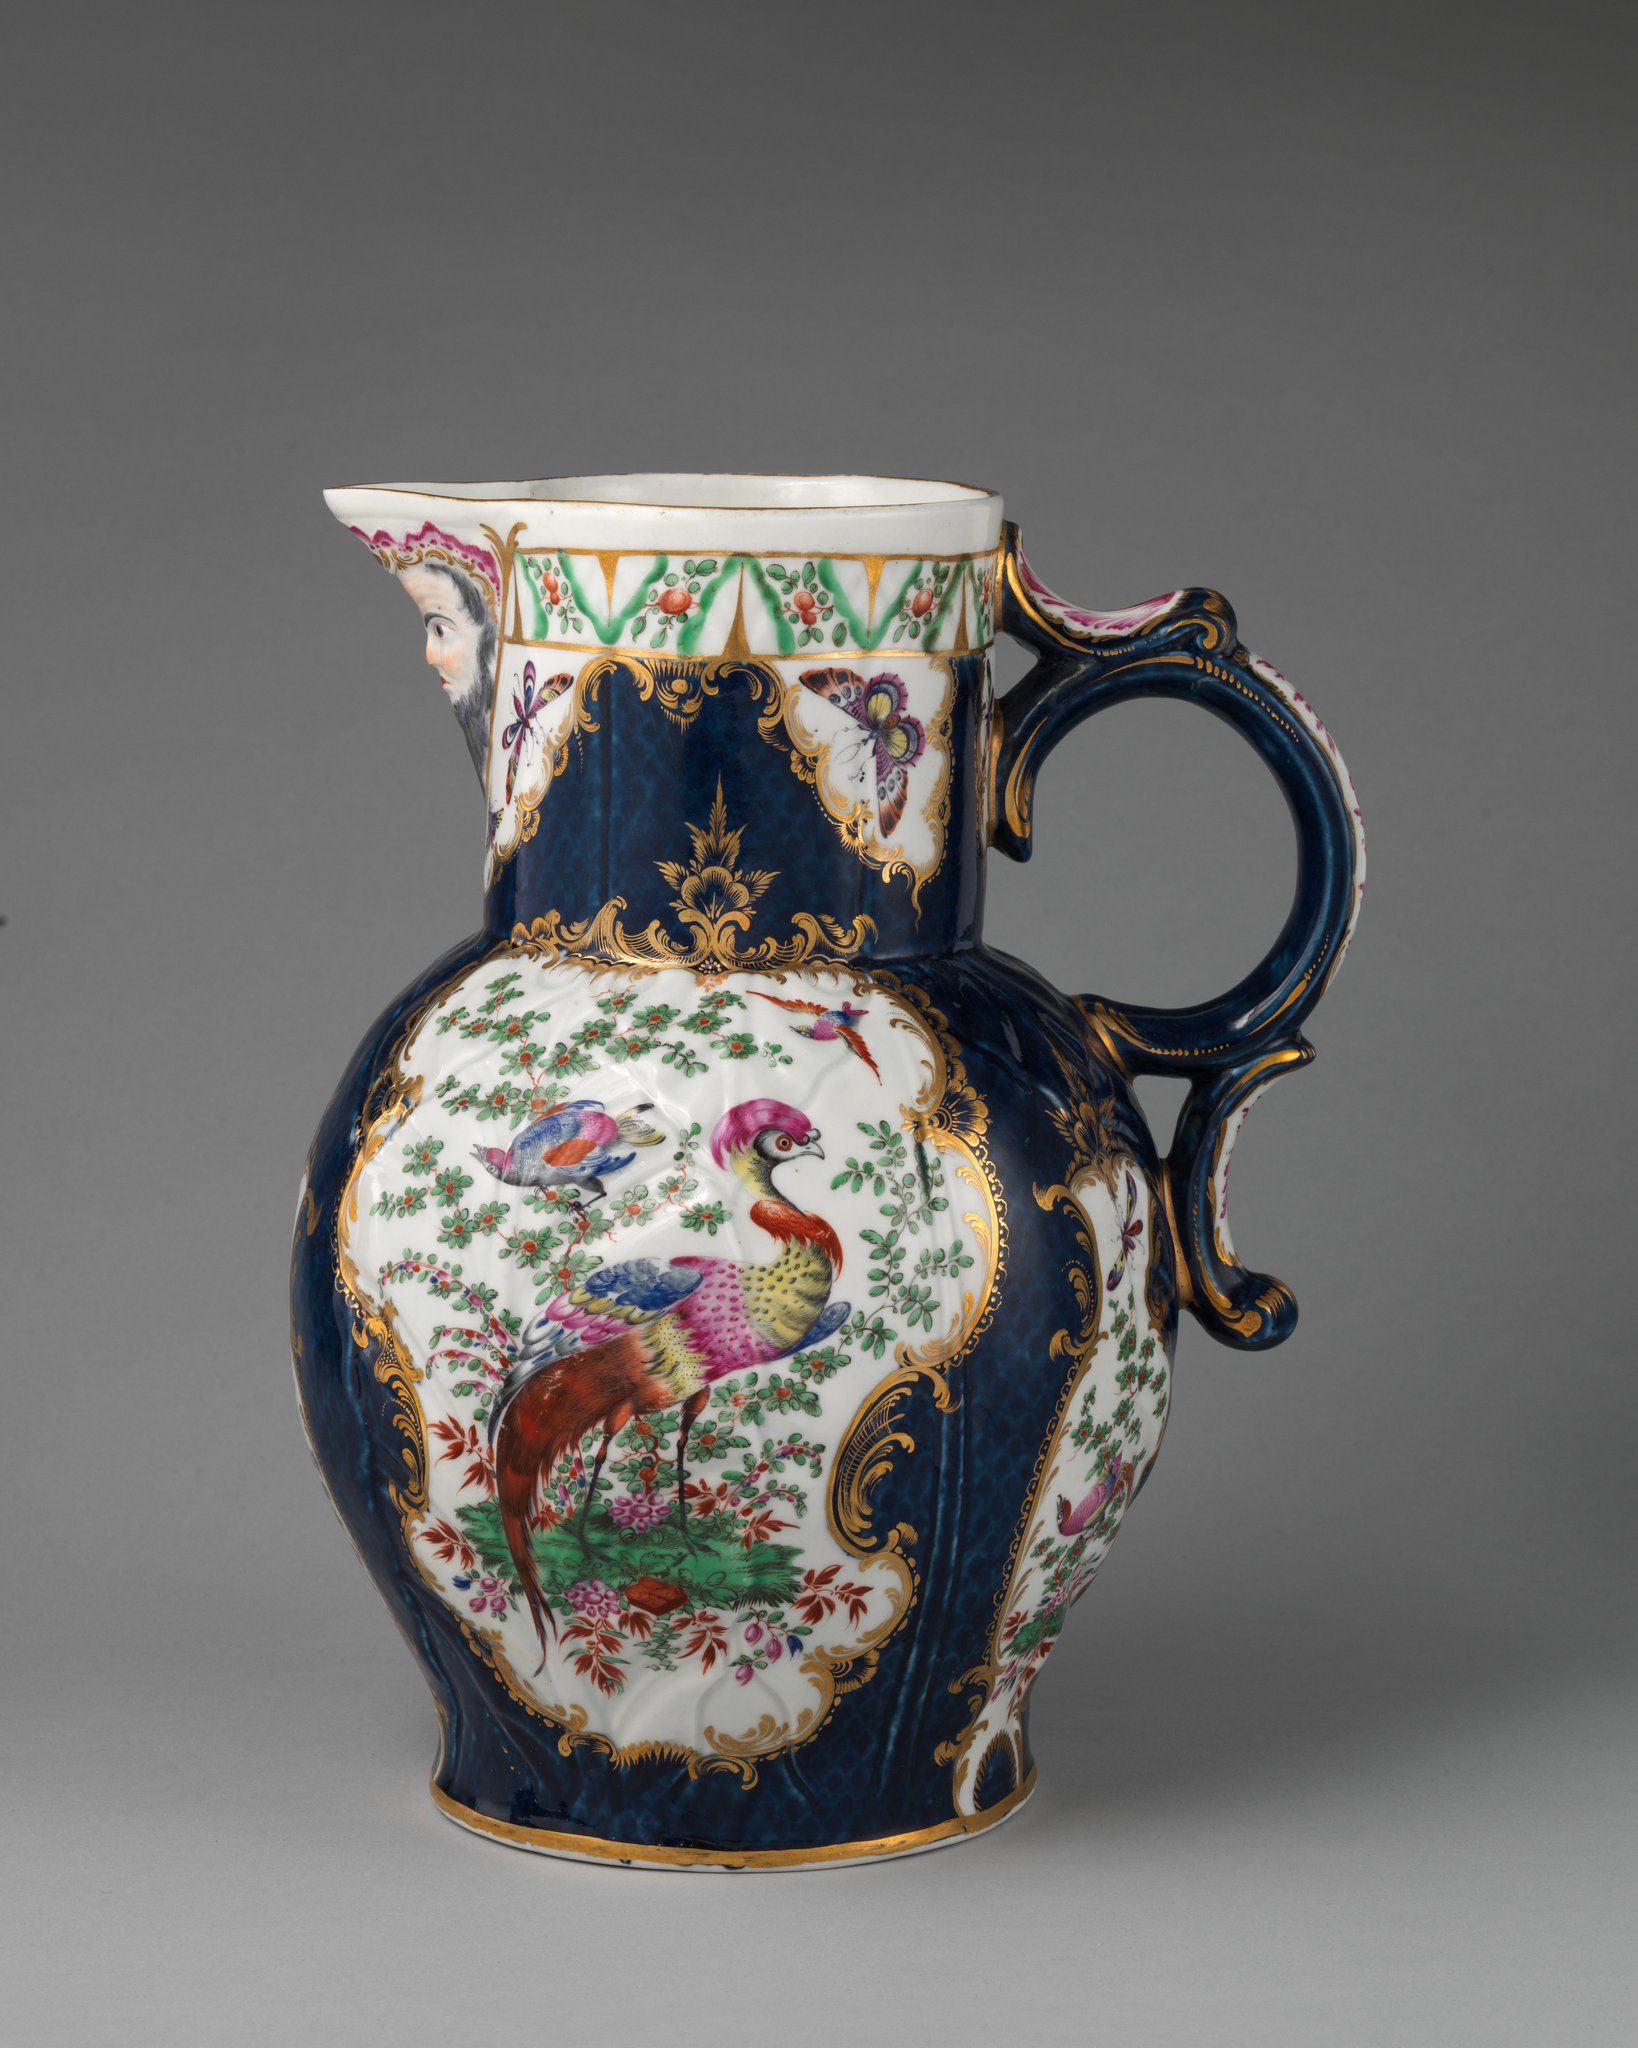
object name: jug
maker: worcester factory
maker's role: factory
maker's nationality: british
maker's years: 1751-2008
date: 1770-1775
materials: soft paste porcelain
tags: birds